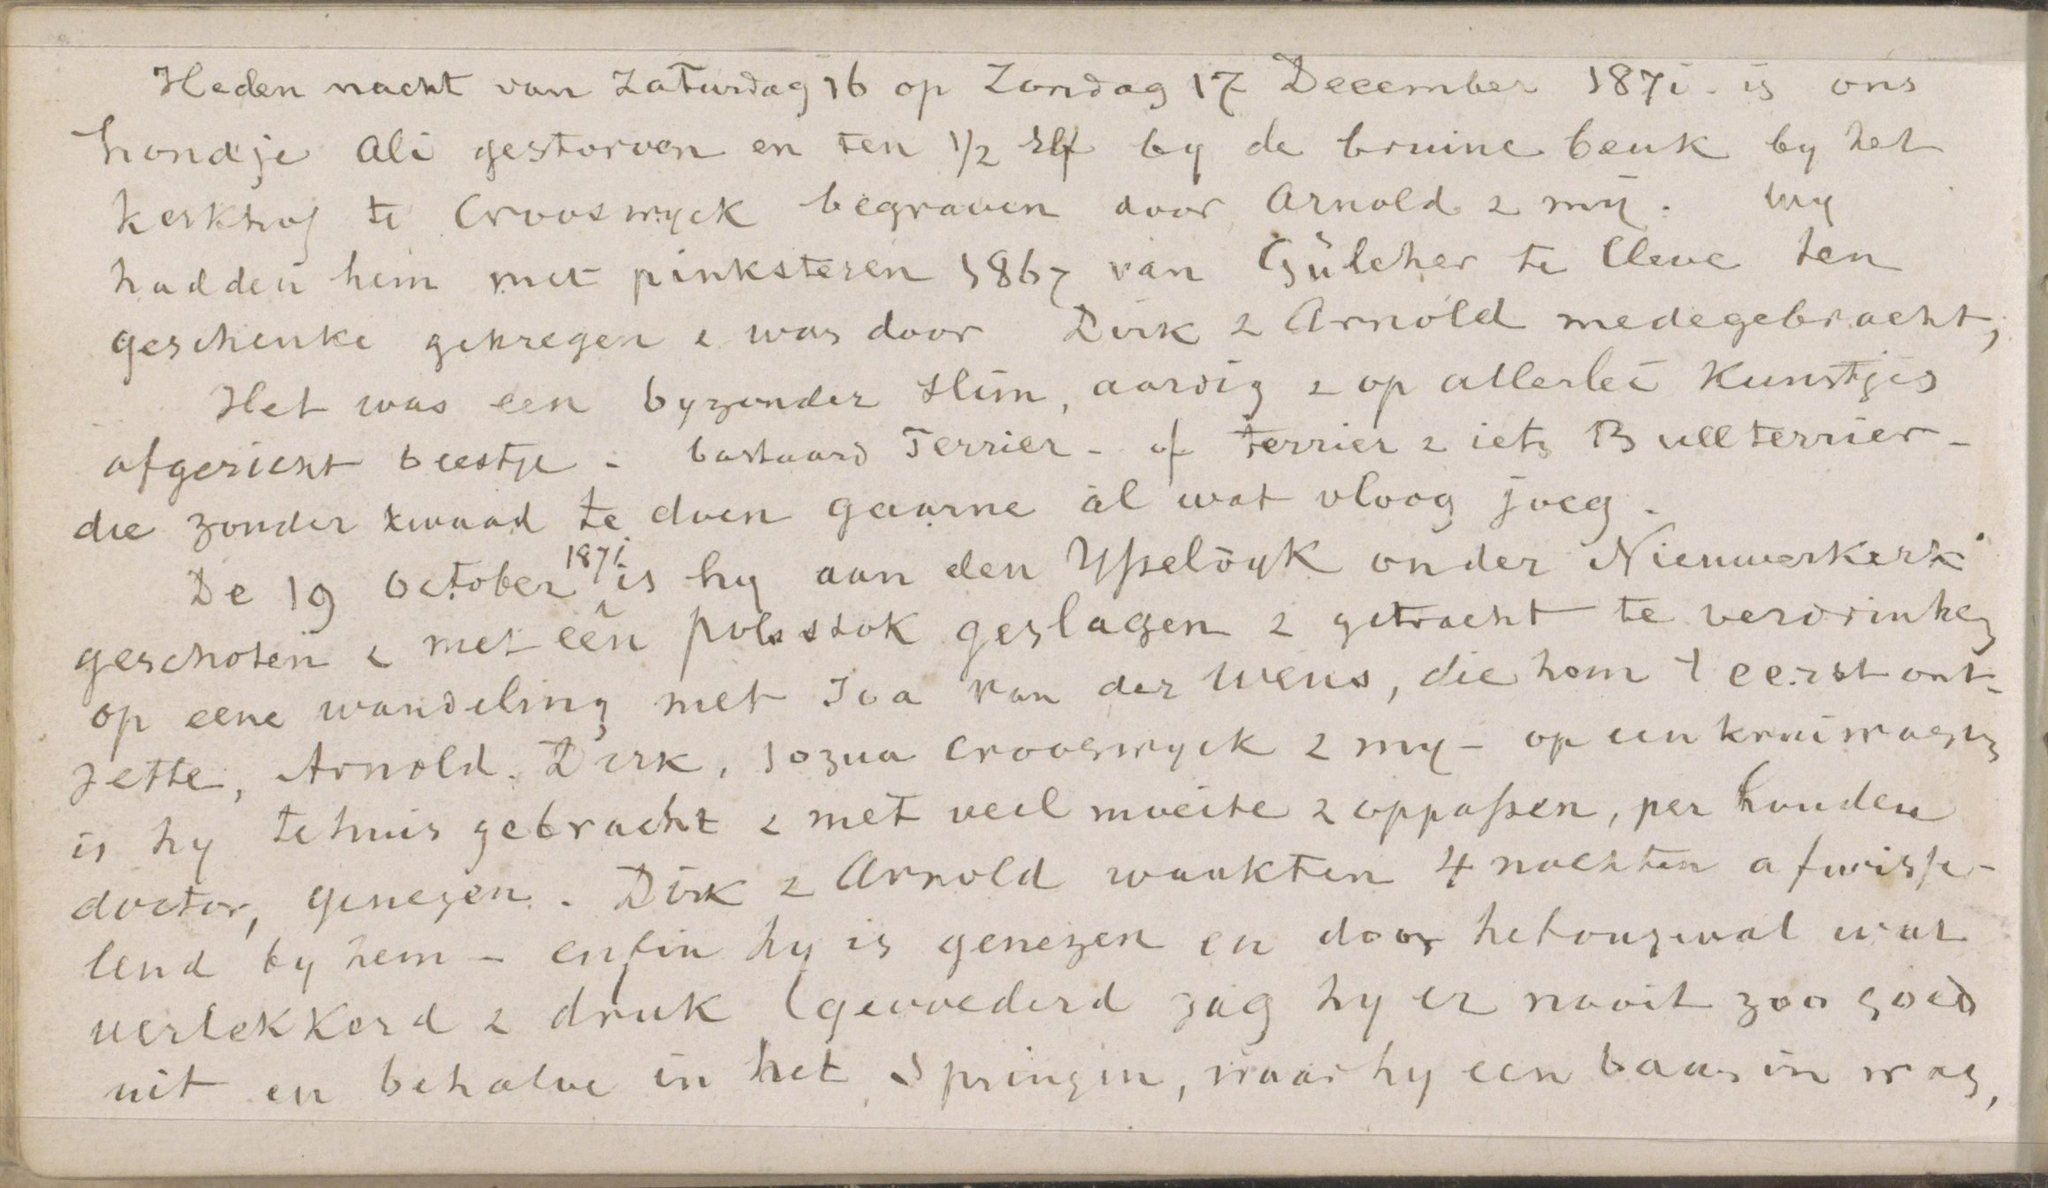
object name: sketchbook leaf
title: Verhaal over Tavenraats overleden hond Ali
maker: johannes tavenraat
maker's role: draughtsman, painter, print maker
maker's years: 1809-1881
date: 1812-1871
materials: ink, paper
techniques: pen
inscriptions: date and inscription: ‘[...]’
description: Blad 93 verso uit een schetsboek met 98 bladen.